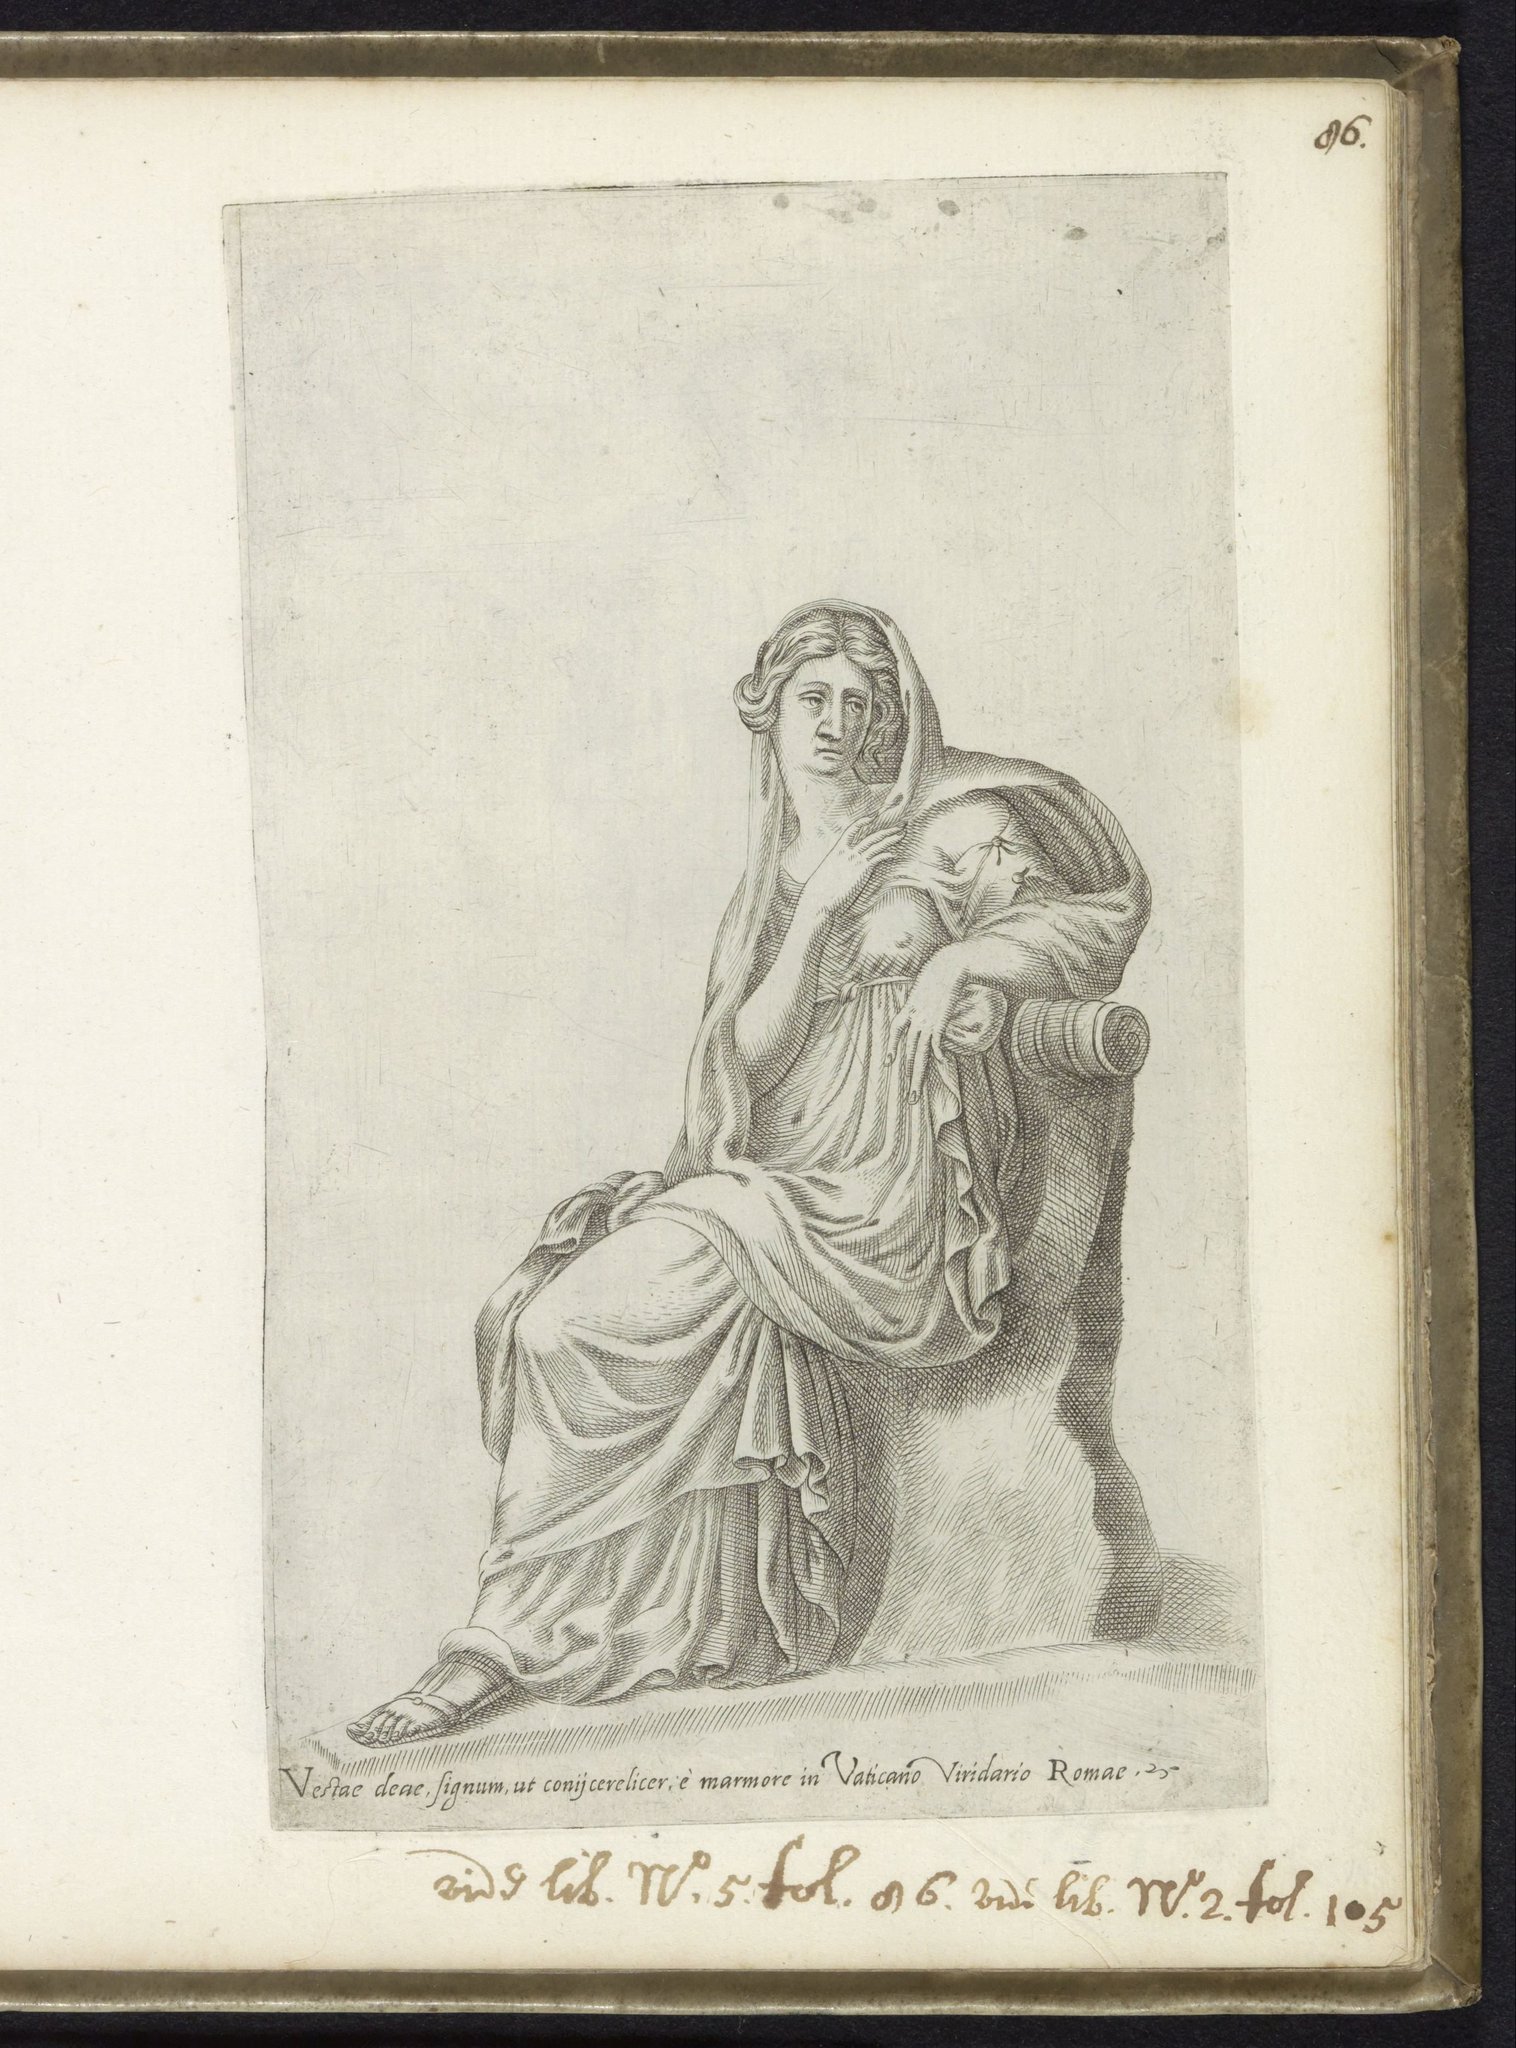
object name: album leaf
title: Sculpturen uit de oudheid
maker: Anonymous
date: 1600-1699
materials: paper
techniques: engraving, etching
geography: italy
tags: vestal virgin(s), piece of sculpture, reproduction of a piece of sculpture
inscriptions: inscription: ‘Ende lib. No. 5. fol. 86. Ende lib. No. 2. fol. 105’, inscription: ‘Ende lib. No. 20. fol. 41. Ende lib. No. 2. fol. 105.’, number: ‘86’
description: Deze prent maakt deel uit van een reeks van ten minste 50 prenten van sculpturen uit de oudheid.